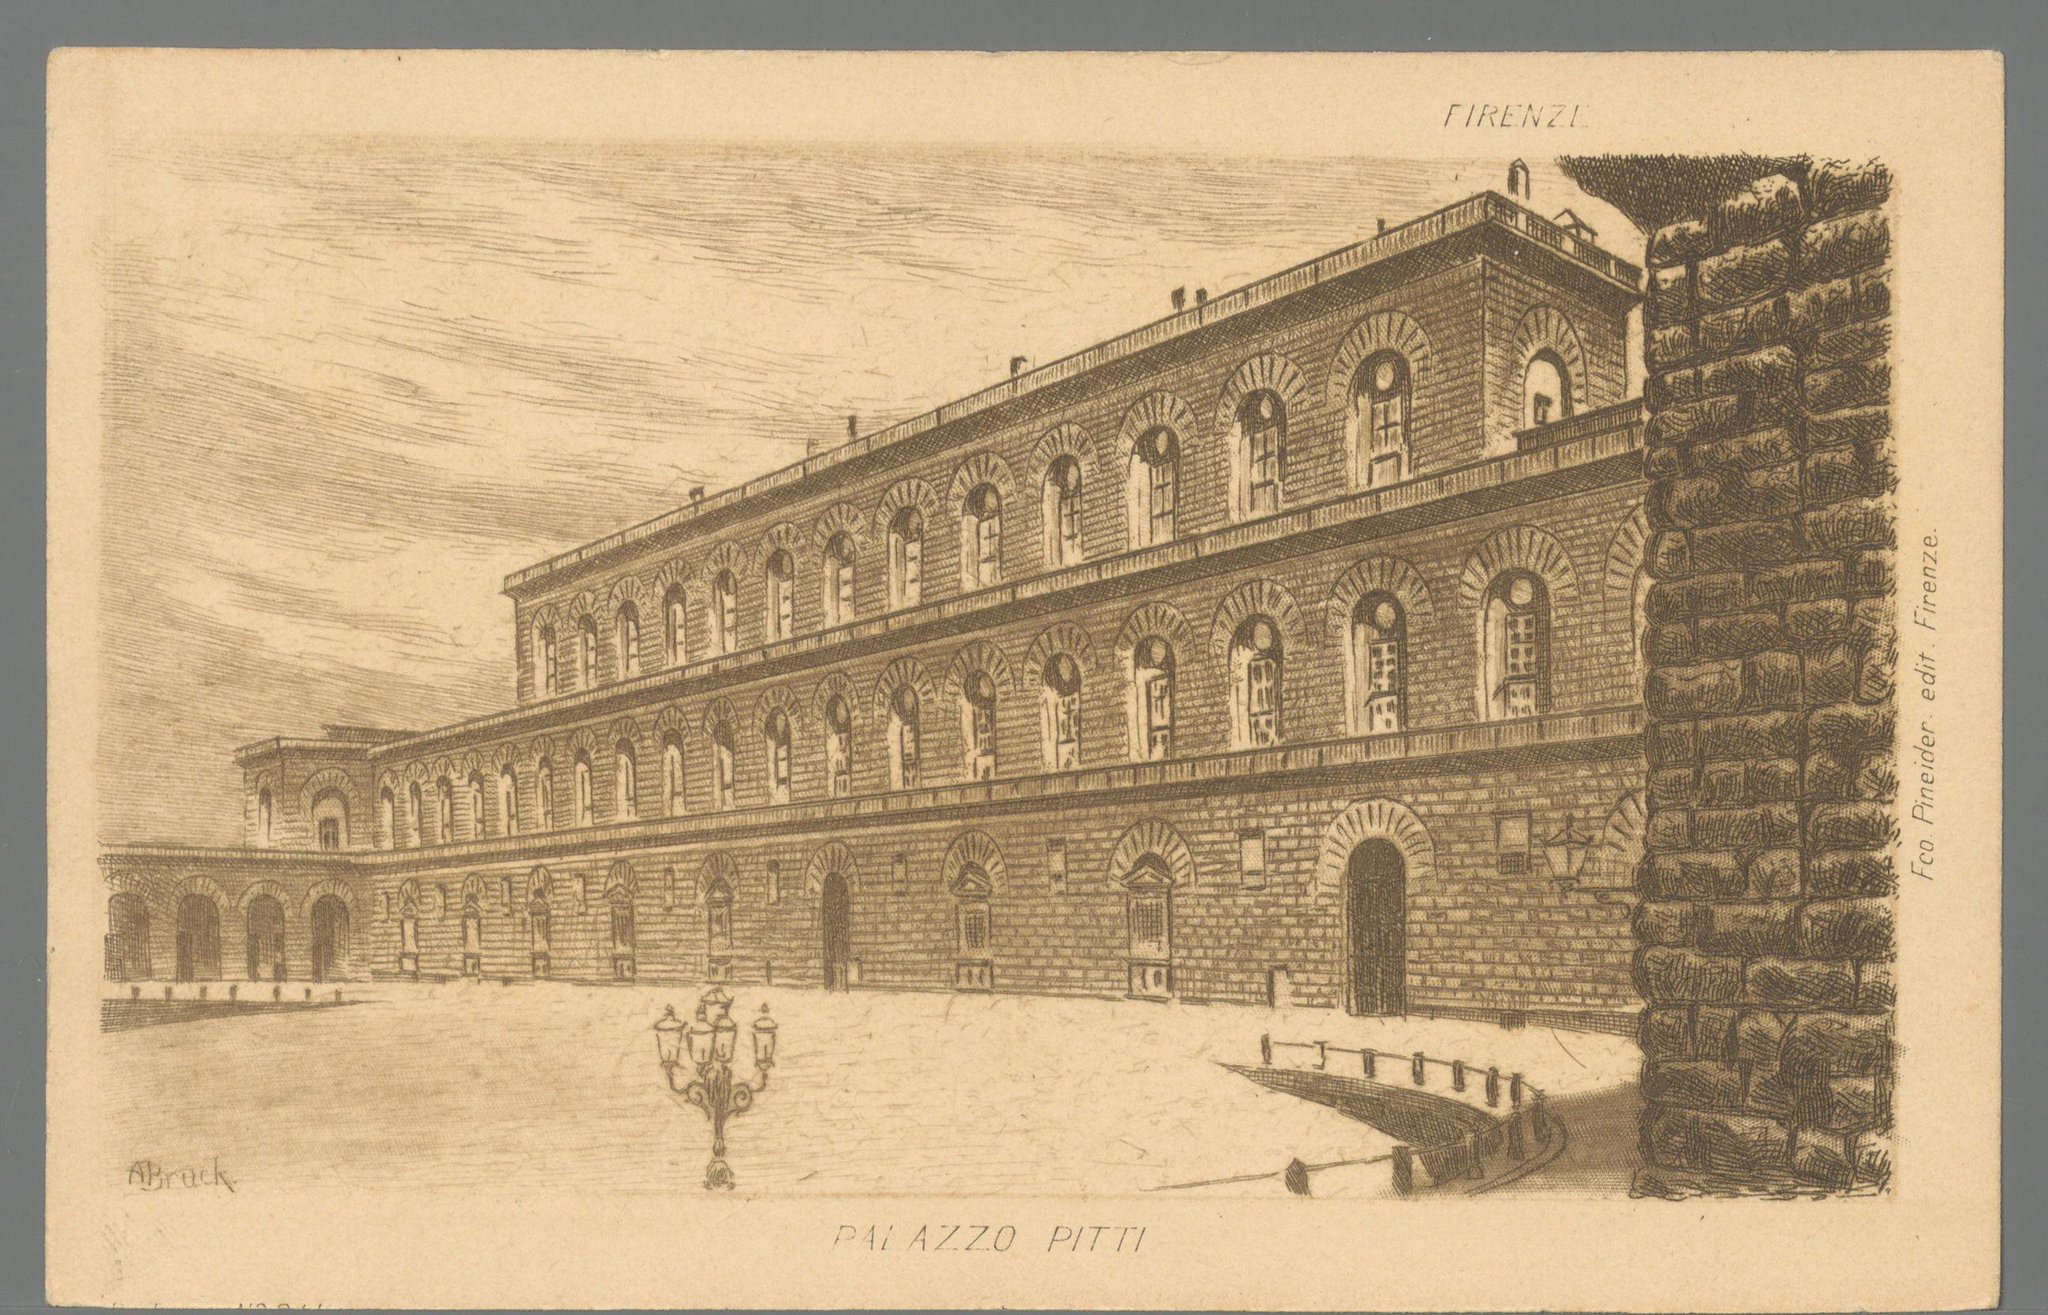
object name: ansichtkaart, prentbriefkaart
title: Firenze. Palazzo Pitti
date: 1906-1930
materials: cardboard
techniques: photograph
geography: florence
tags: square, place, circus, etc., palace